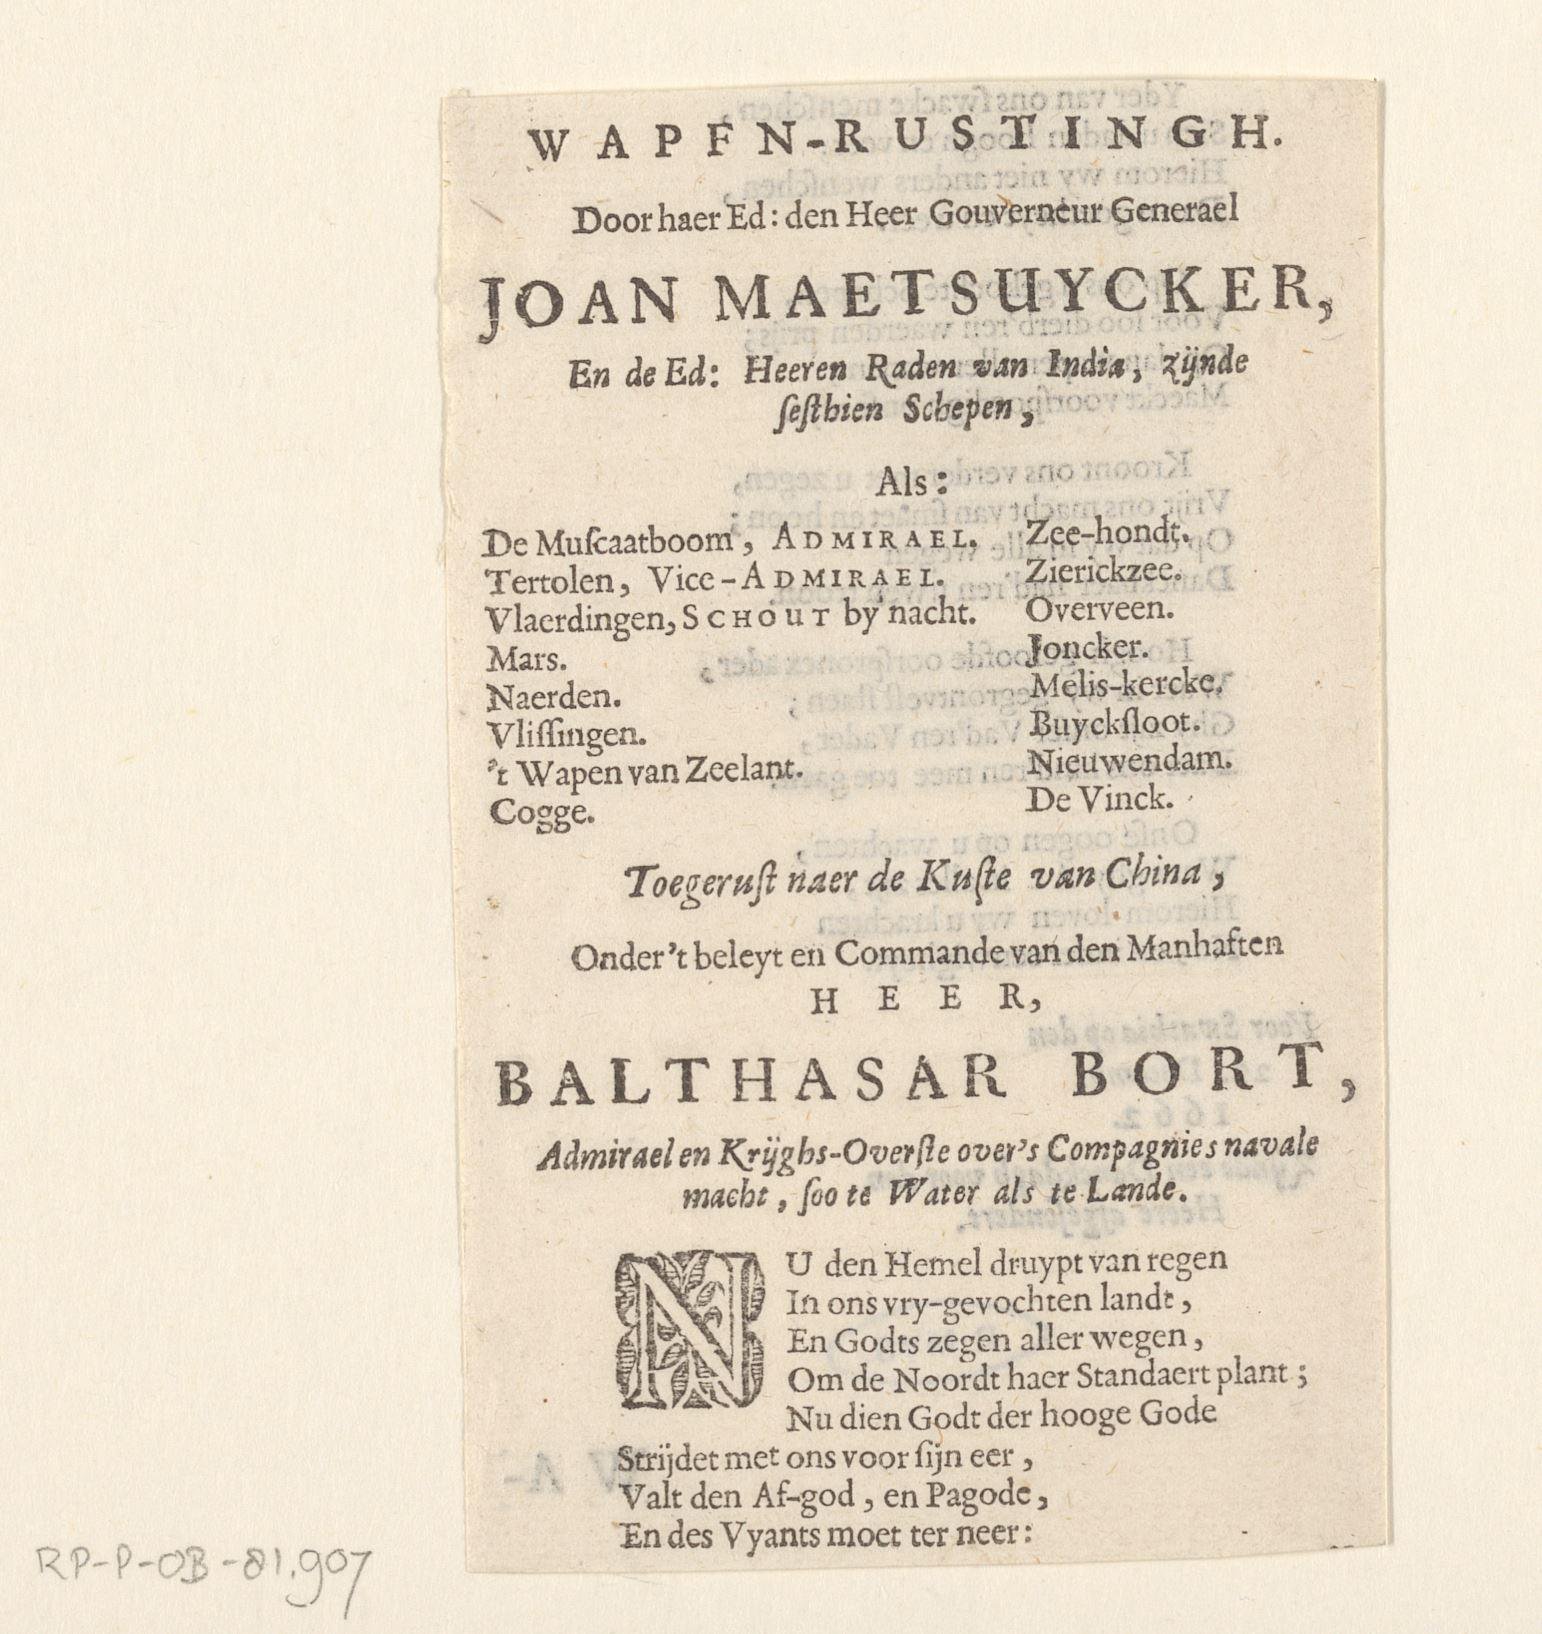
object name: text sheet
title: Blad met vers ter ere van Bathasar Bort, 1662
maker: Anonymous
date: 1662-1670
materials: paper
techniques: letterpress printing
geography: northern netherlands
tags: japan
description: Blad met een vers ter ere van Bathasar Bort, 22 december 1662. Tekstblad aan beide zijden bedrukt. In verband met de expeditie van de VOC van 1662-1668 onder leiding van Balthasar Bort tegen de Chinese krijgsheer Coxinga.